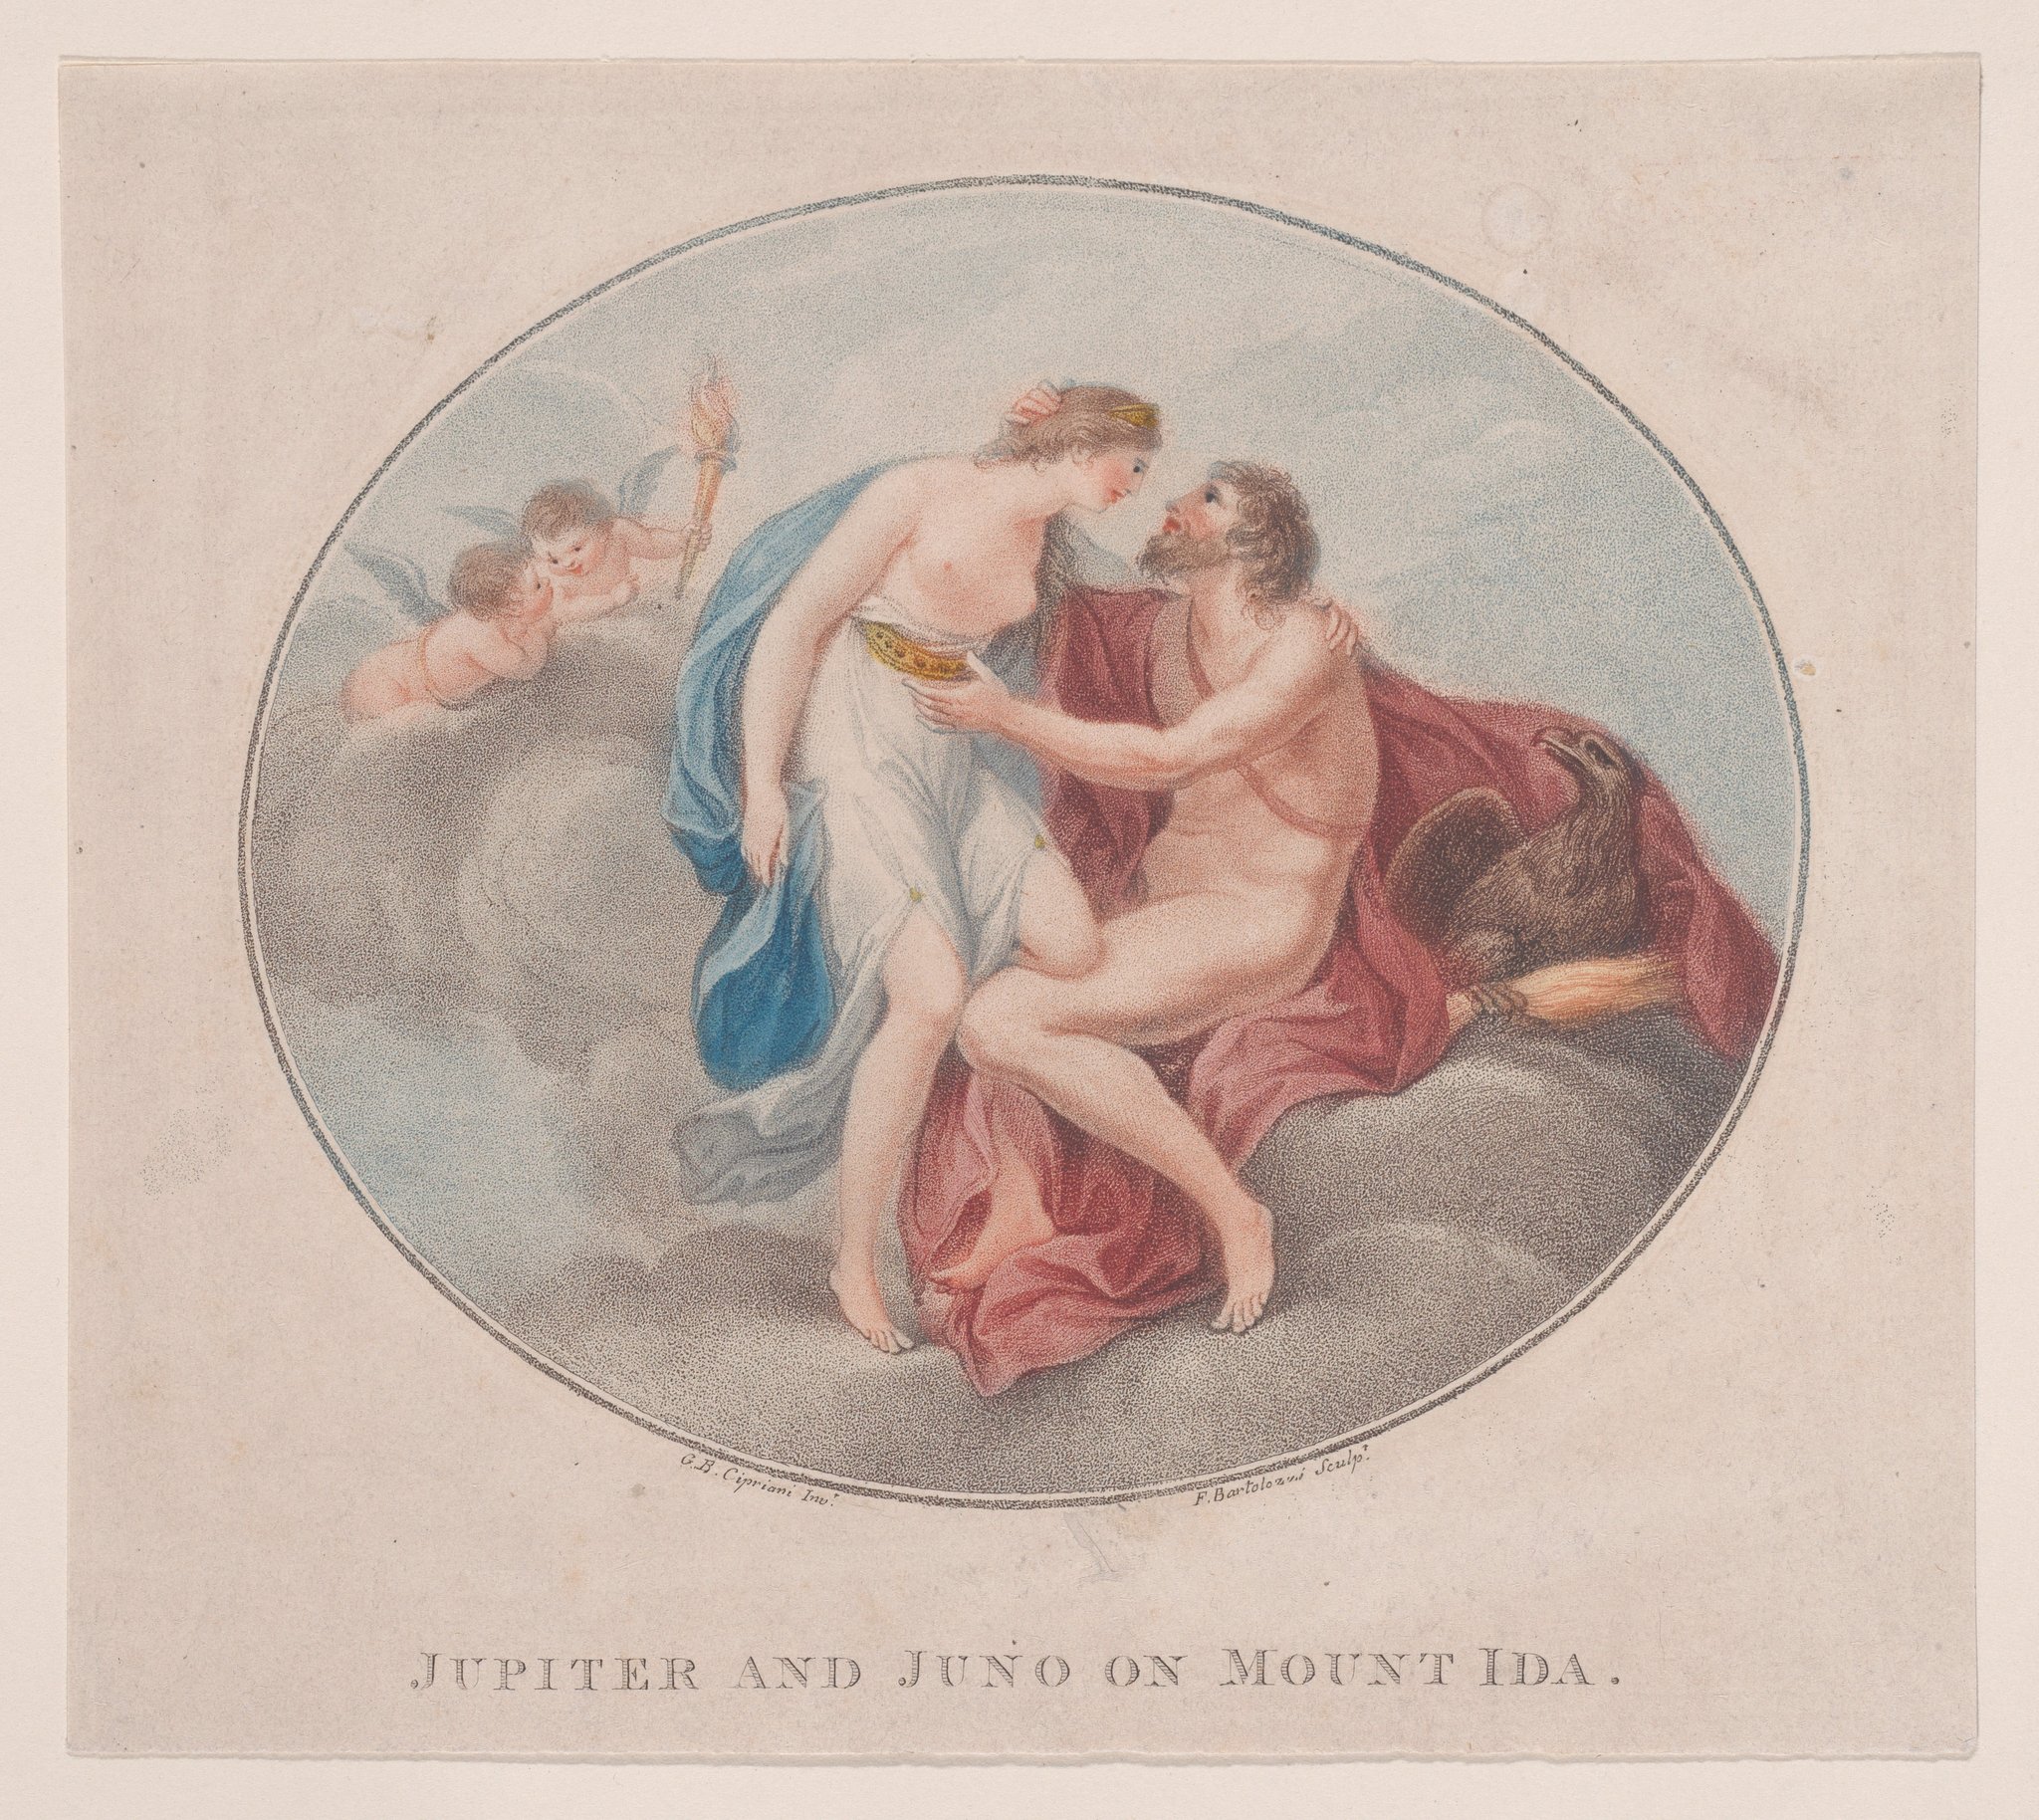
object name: print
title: Jupiter and Juno on Mount Ida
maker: francesco bartolozzi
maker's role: artist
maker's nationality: italian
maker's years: 1728-1815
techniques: etching, printing, engraving